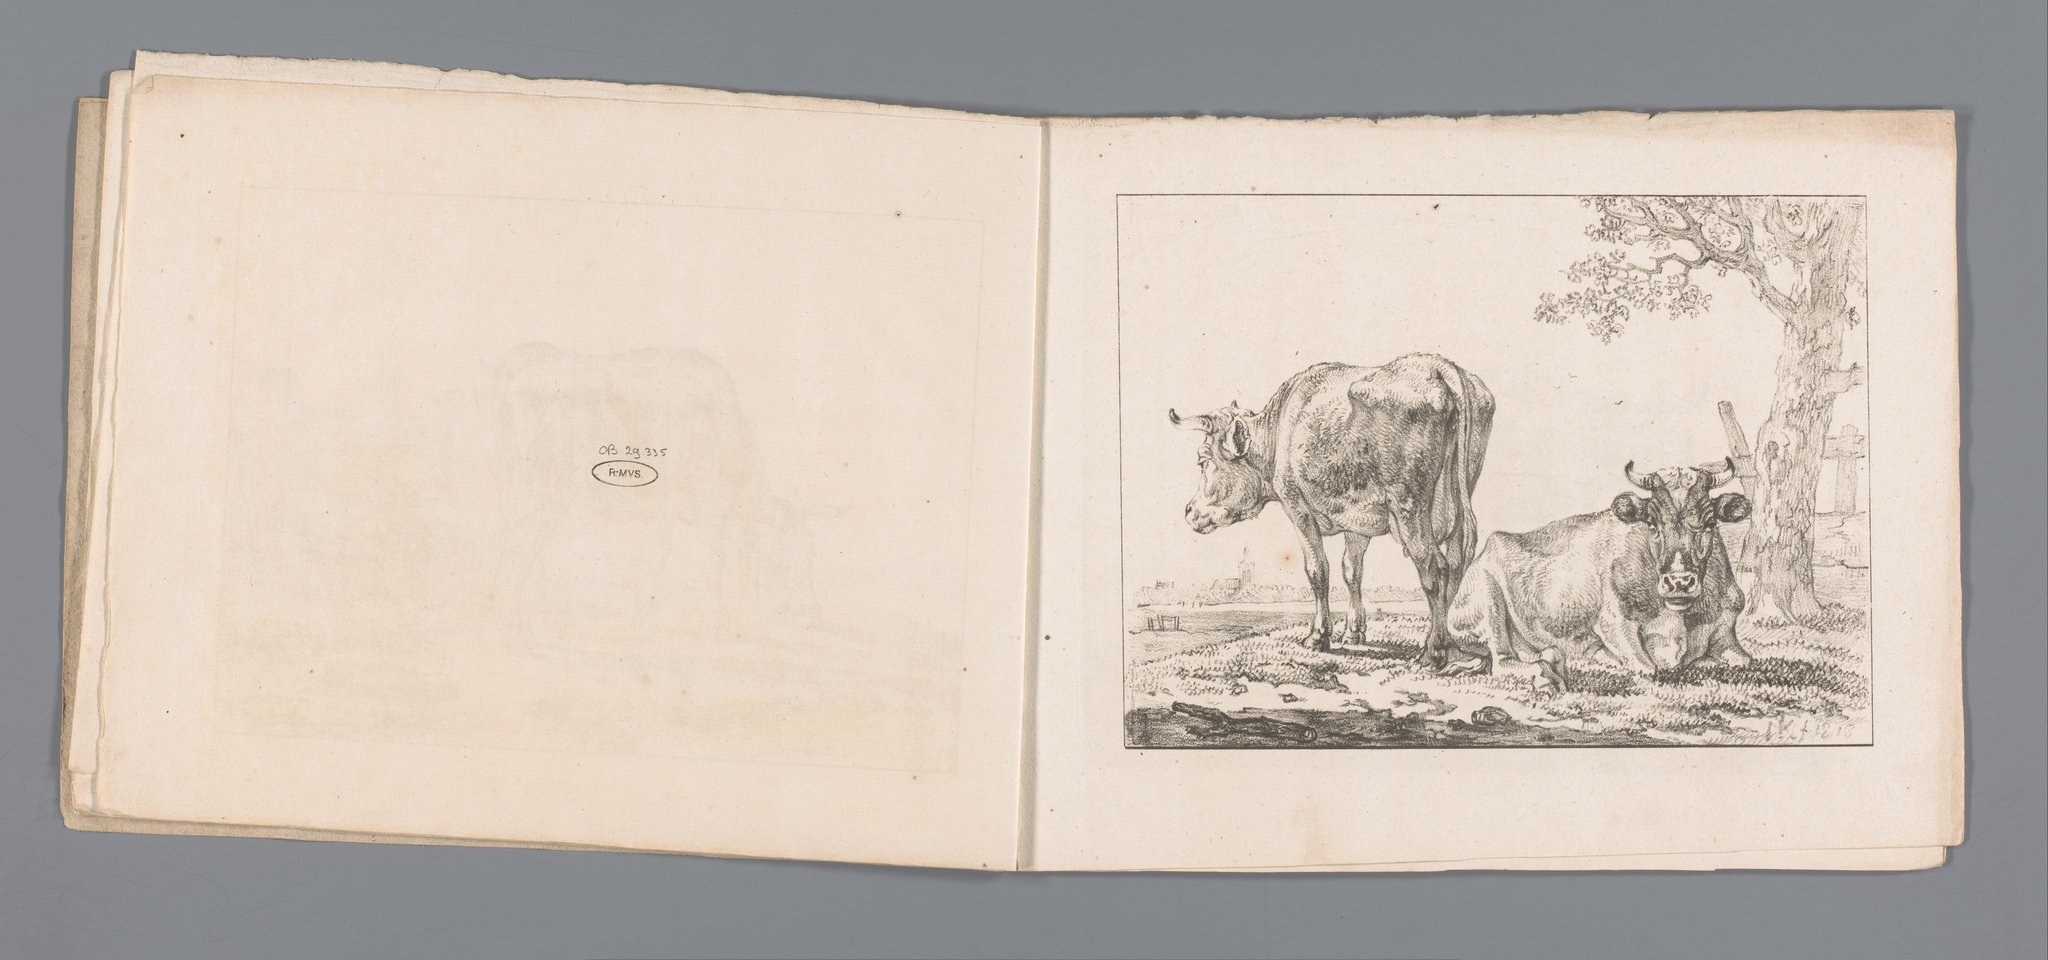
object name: print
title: Cahier van Studies van diversche Dieren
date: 1818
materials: paper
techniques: lithograph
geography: rotterdam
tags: cow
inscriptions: collector's mark: Lugt 2228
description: Prent vier uit een serie van acht. Jan Kobell (III) is mogelijk de prentmaker van prent twee, vier, vijf en acht van de serie. Zie Moulijn, 1927.